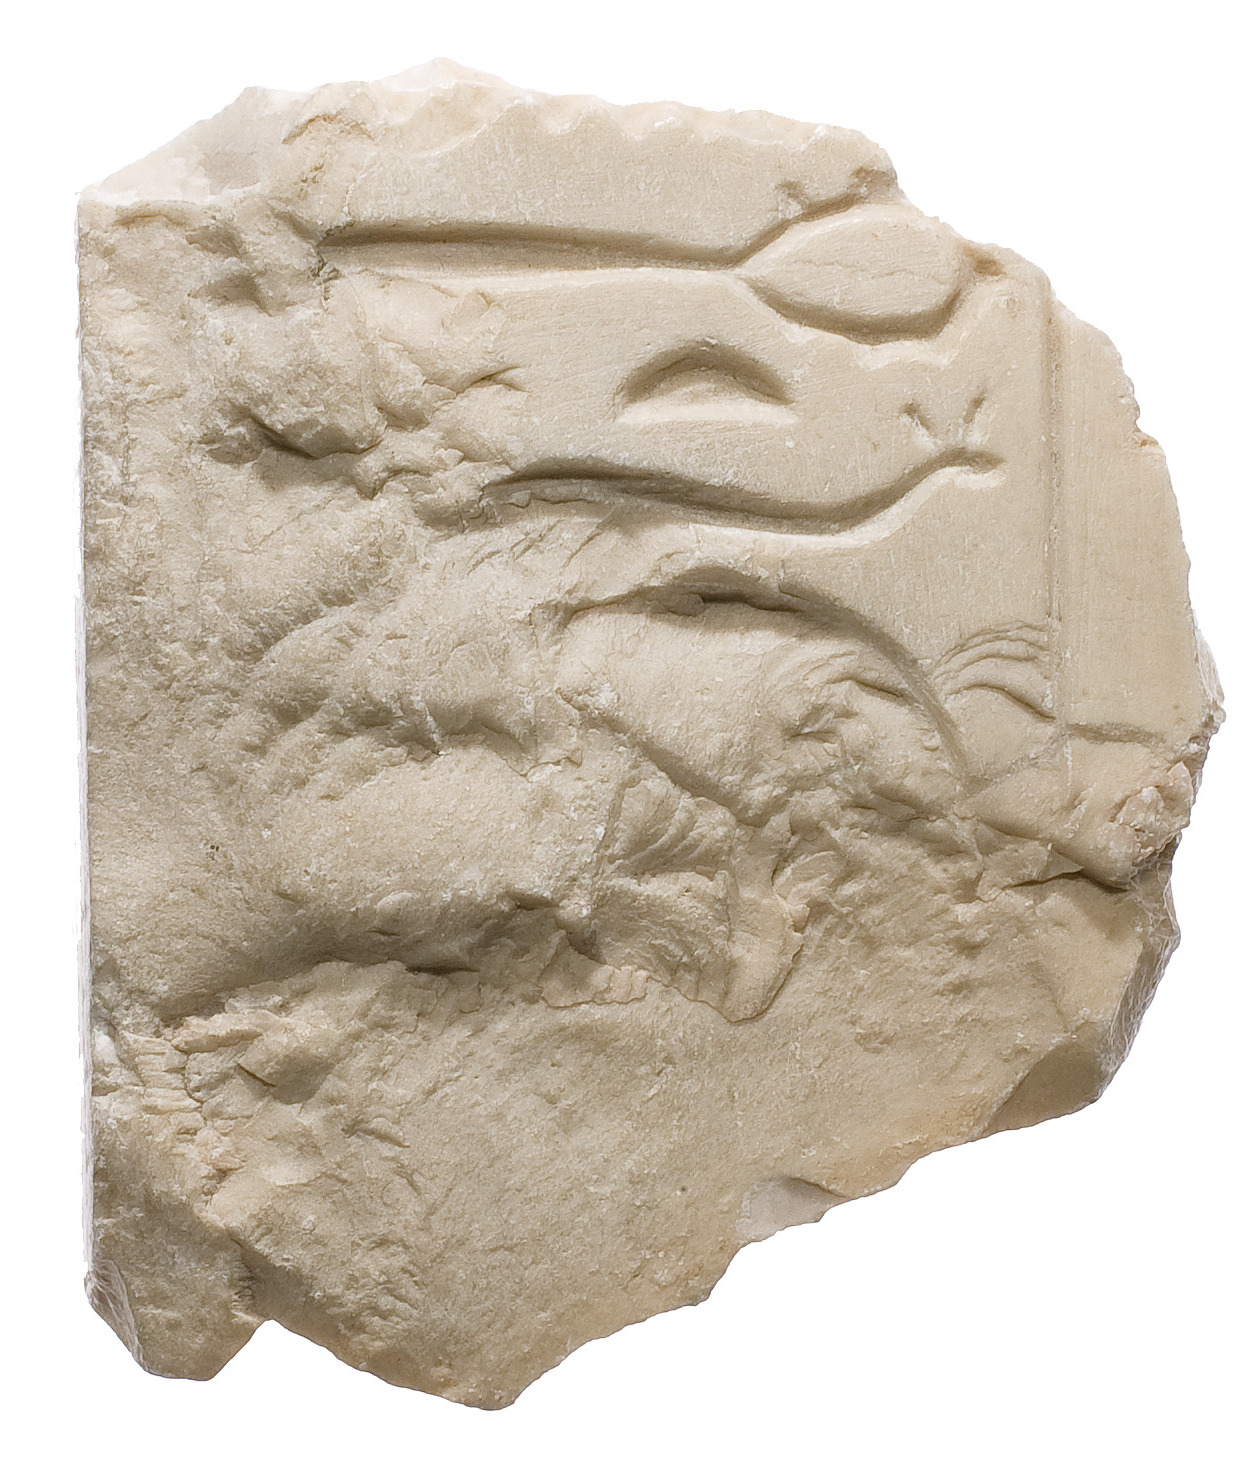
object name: throne block, inscription, border pattern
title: Throne block with princess title and and border pattern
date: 1353-1336 BCE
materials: limestone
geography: egypt